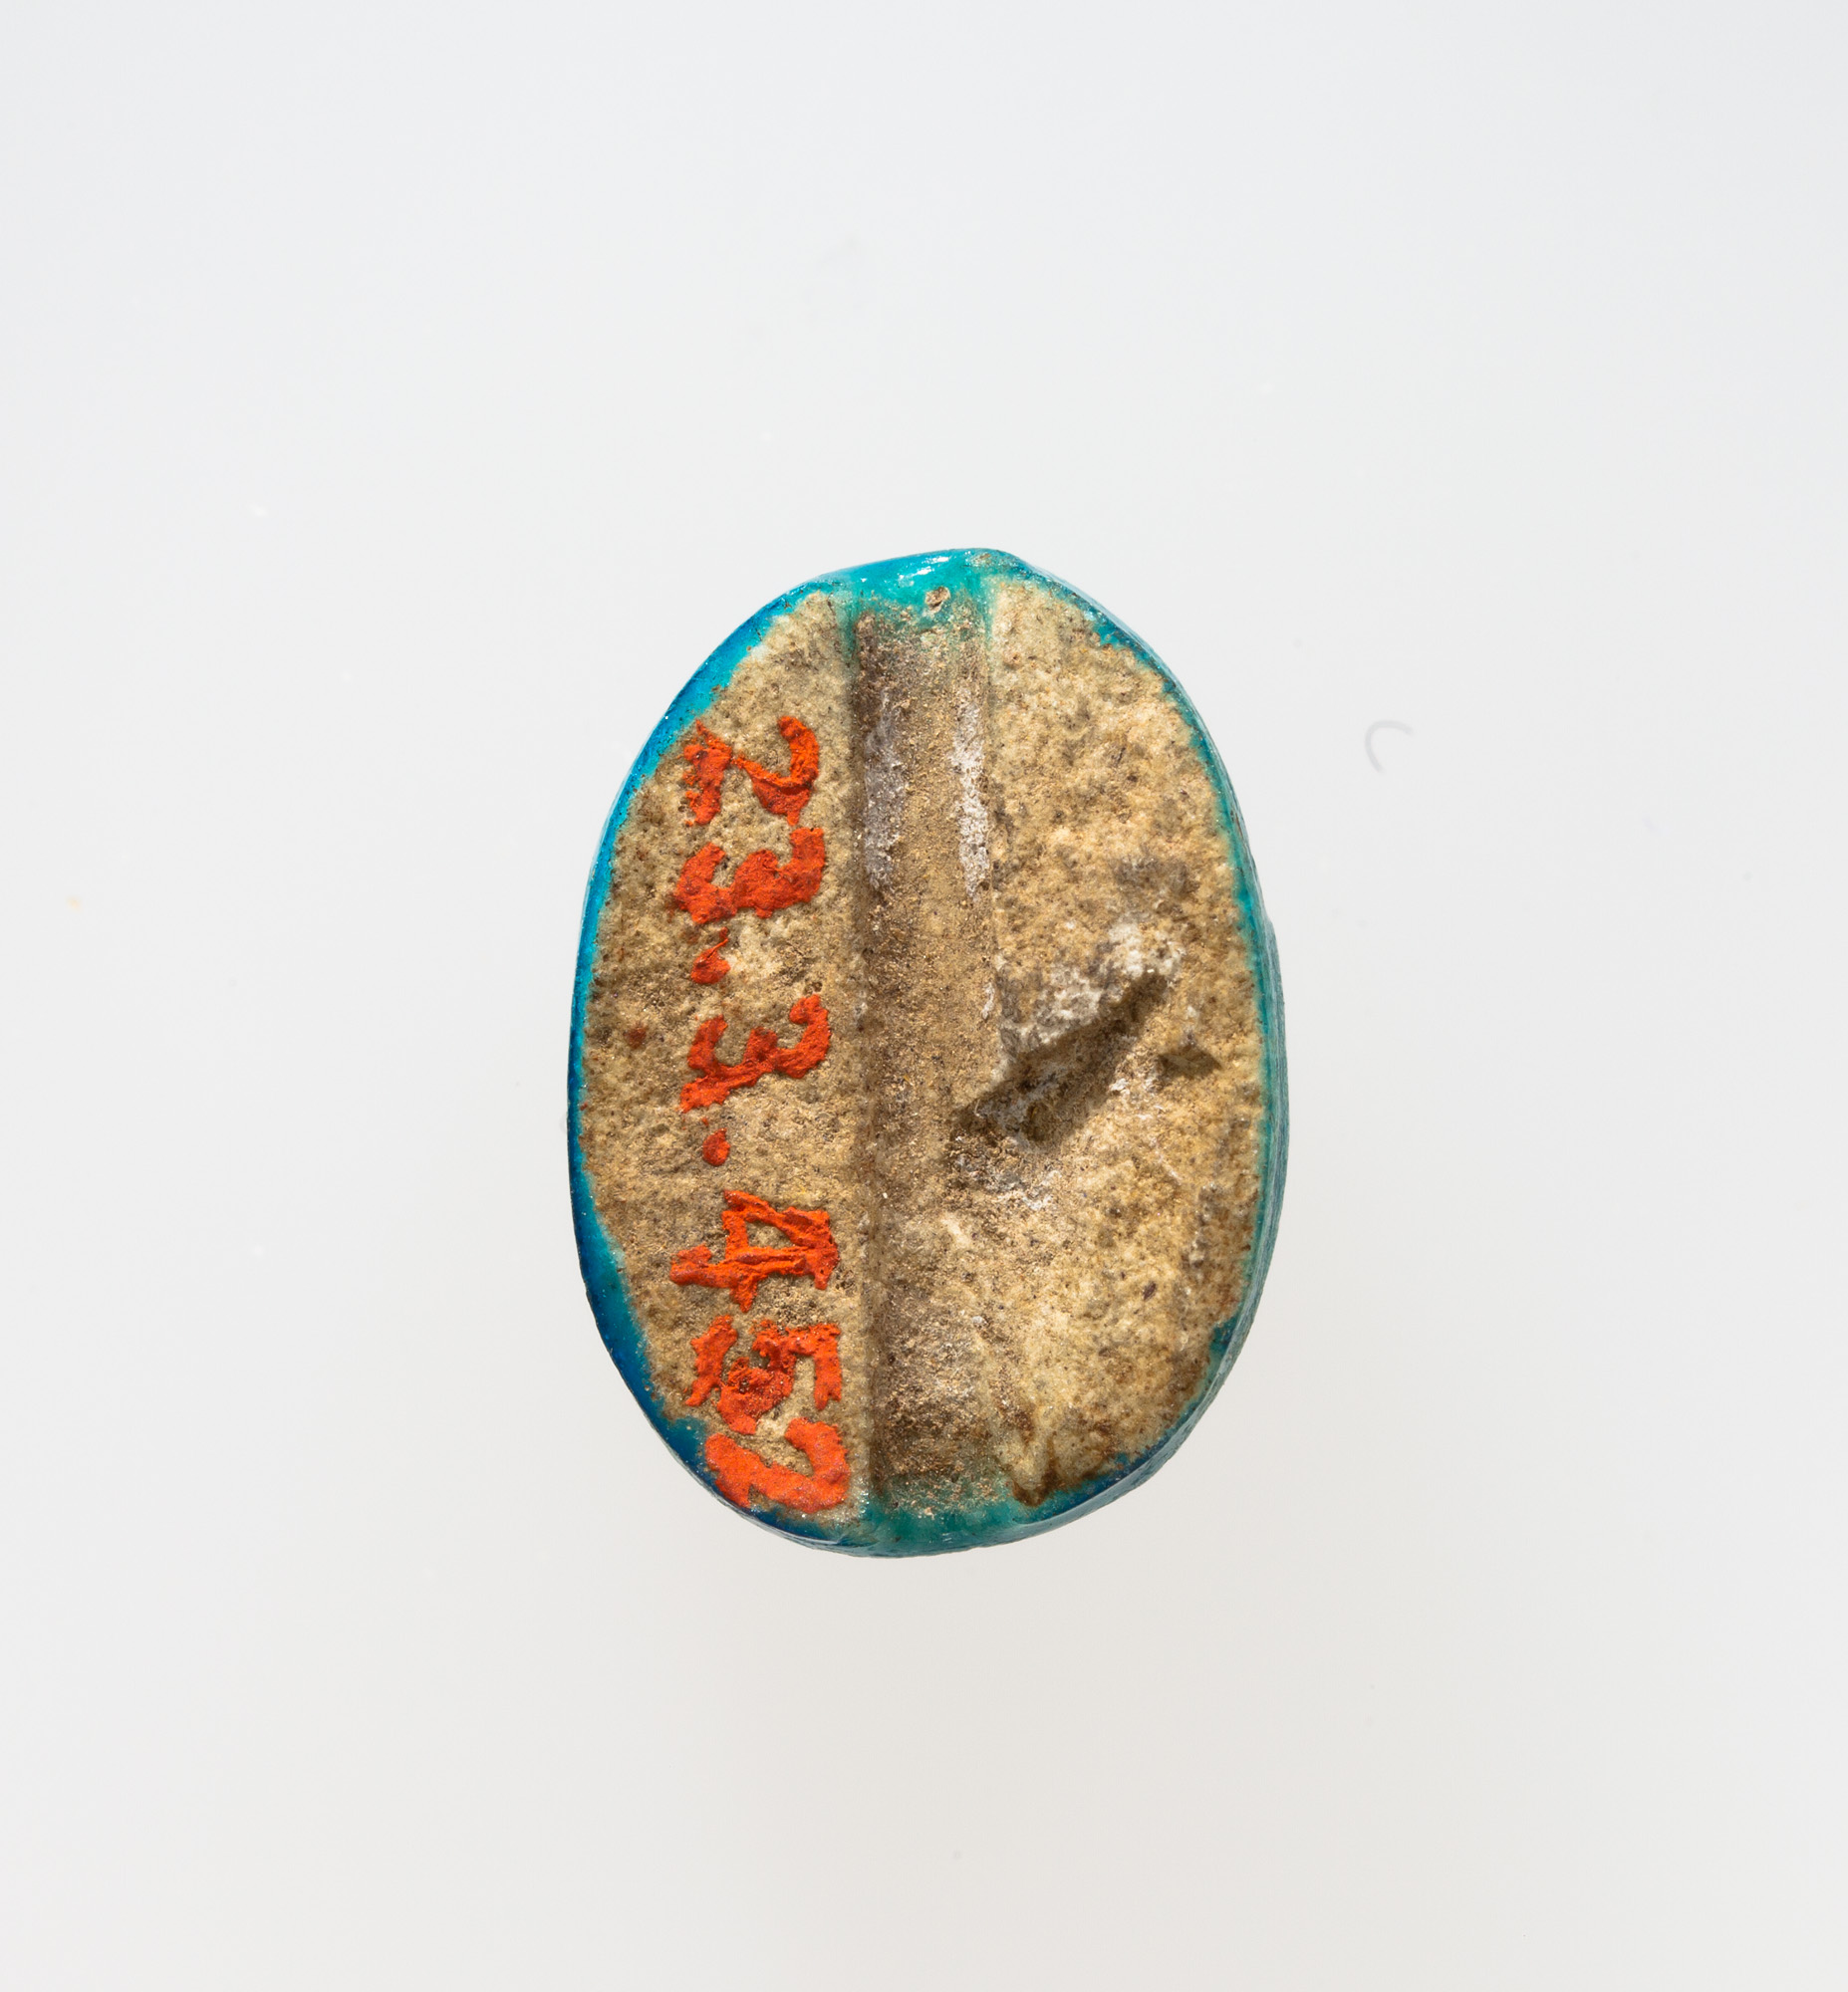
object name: scarab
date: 1479-1458 BCE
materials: faience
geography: egypt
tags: scarabs